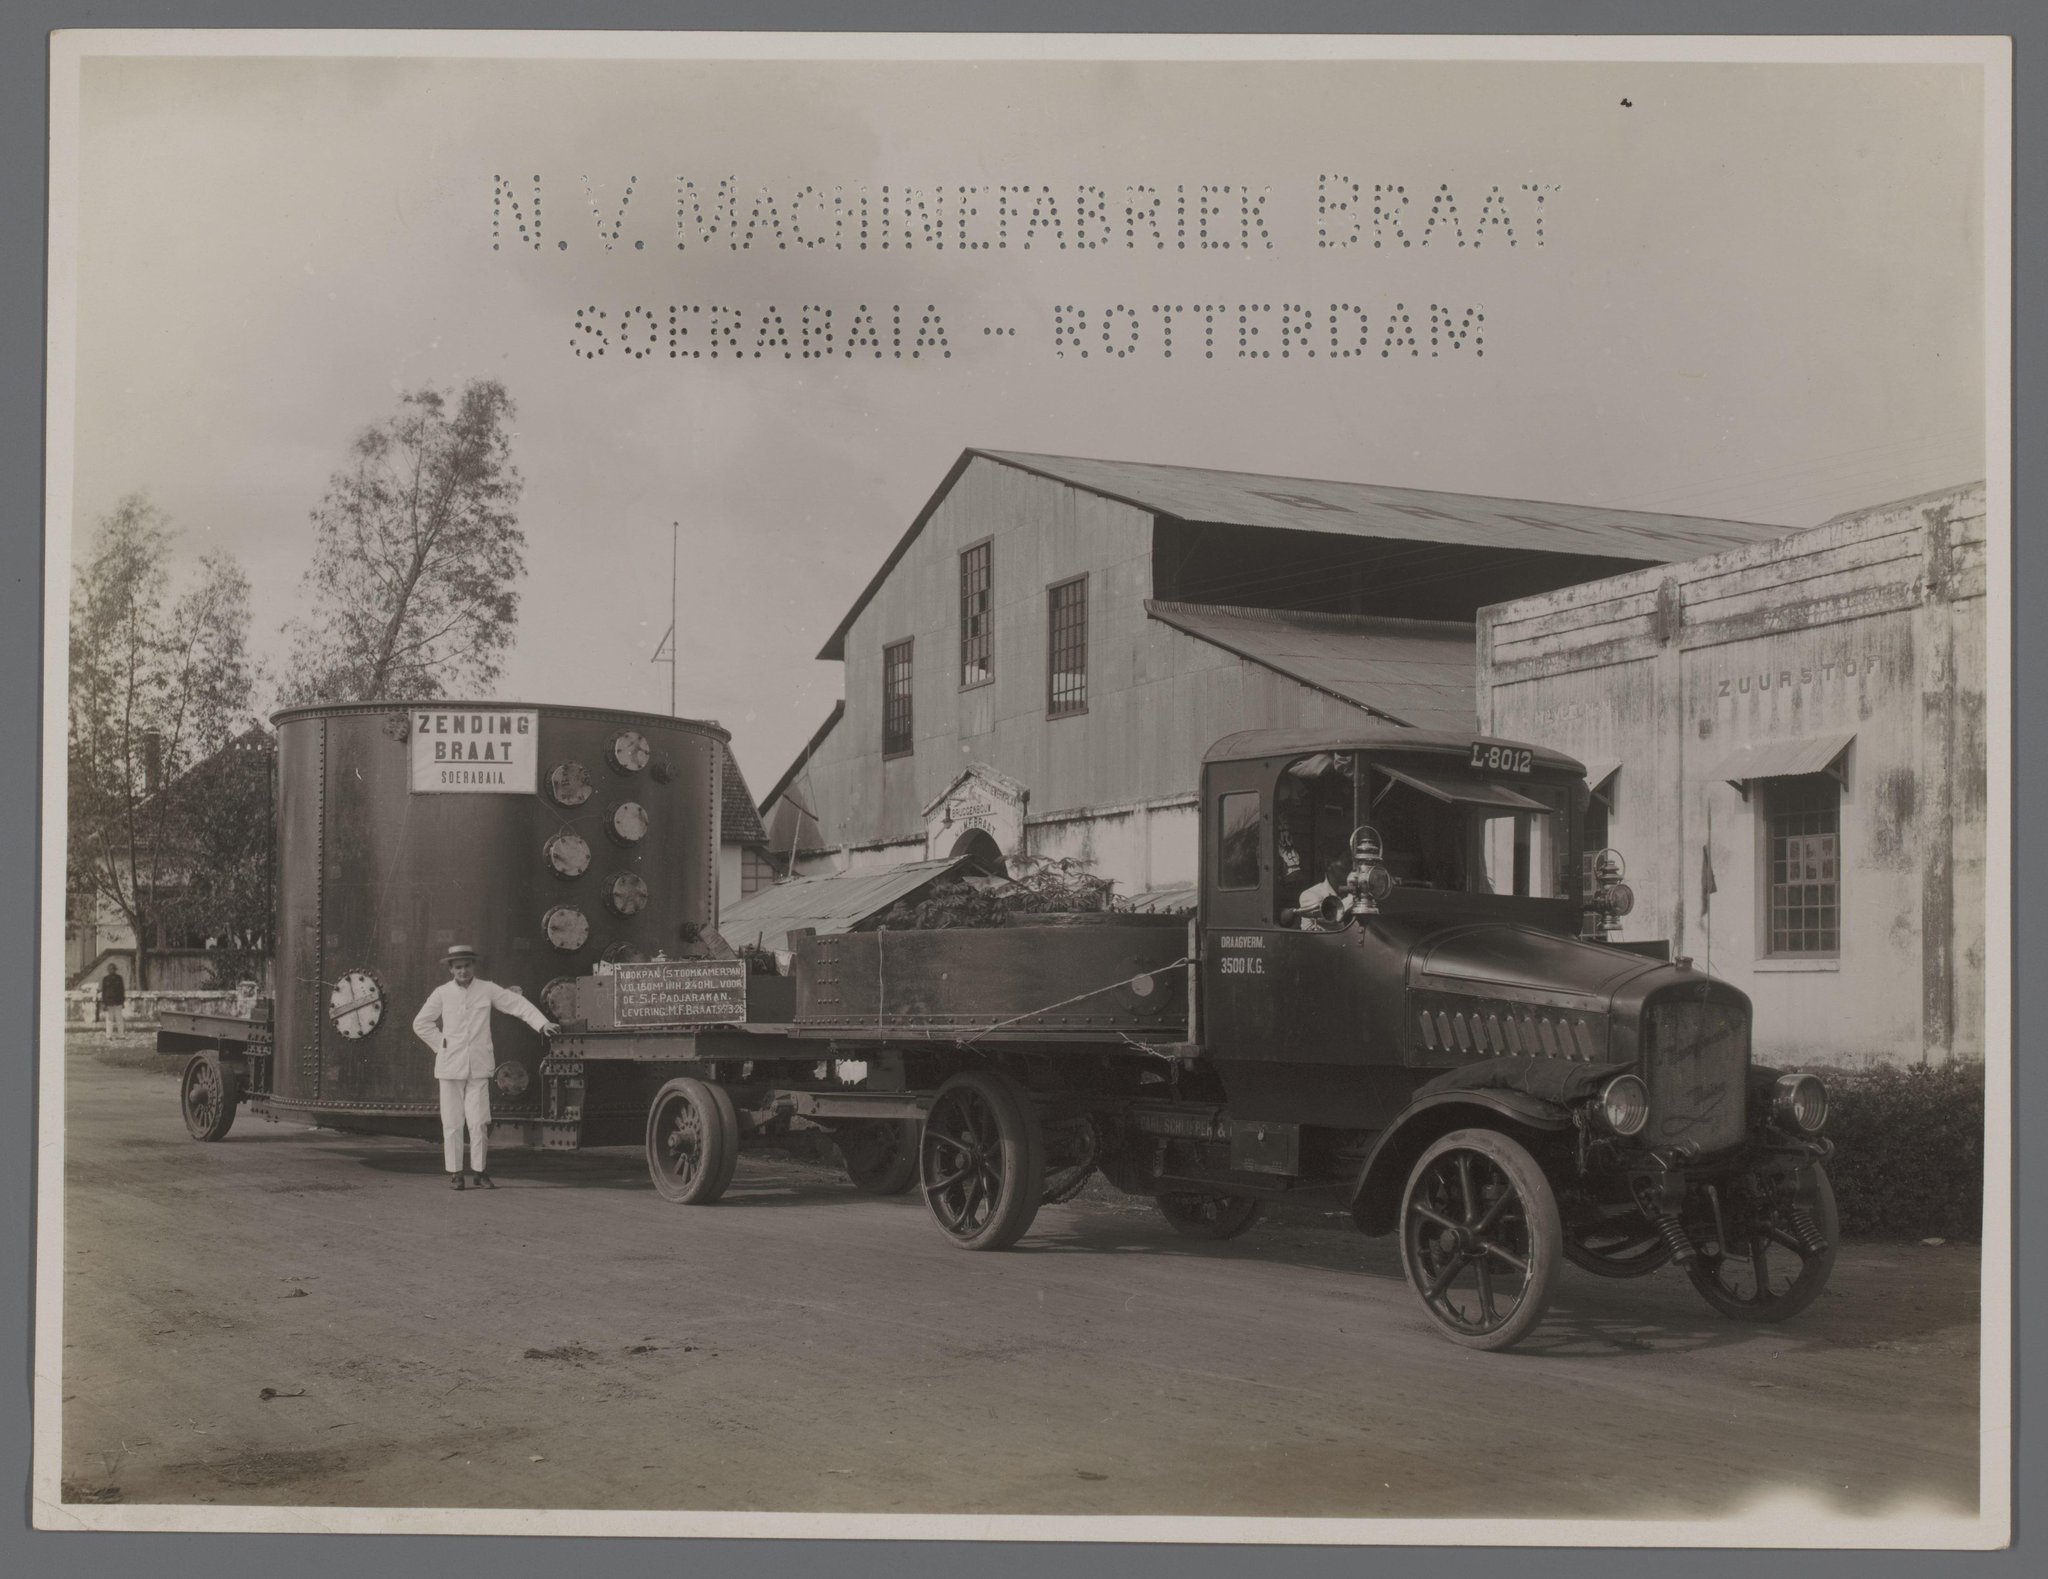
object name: photograph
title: Transport van een kookpan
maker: Anonymous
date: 1926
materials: photographic support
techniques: gelatin silver print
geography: surabaya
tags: truck, van, colonial system, machines; parts of machines; tools and appliances, java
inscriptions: company name: ‘N.V. Machinefabriek Braat / Soerabaia – Rotterdam’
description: Transport van een kookpan op een oplegger achter een vrachtwagen. Vervaardigd in 1926 in Soerabaja en bestemd voor Suikerfabriek Padjarakan. Onderdeel van de multomap met foto's van machines van de N.V. Machinefabriek Braat te Soerabaja, Soekaboemi en Jogyakarta, uit de periode 1908-1942.